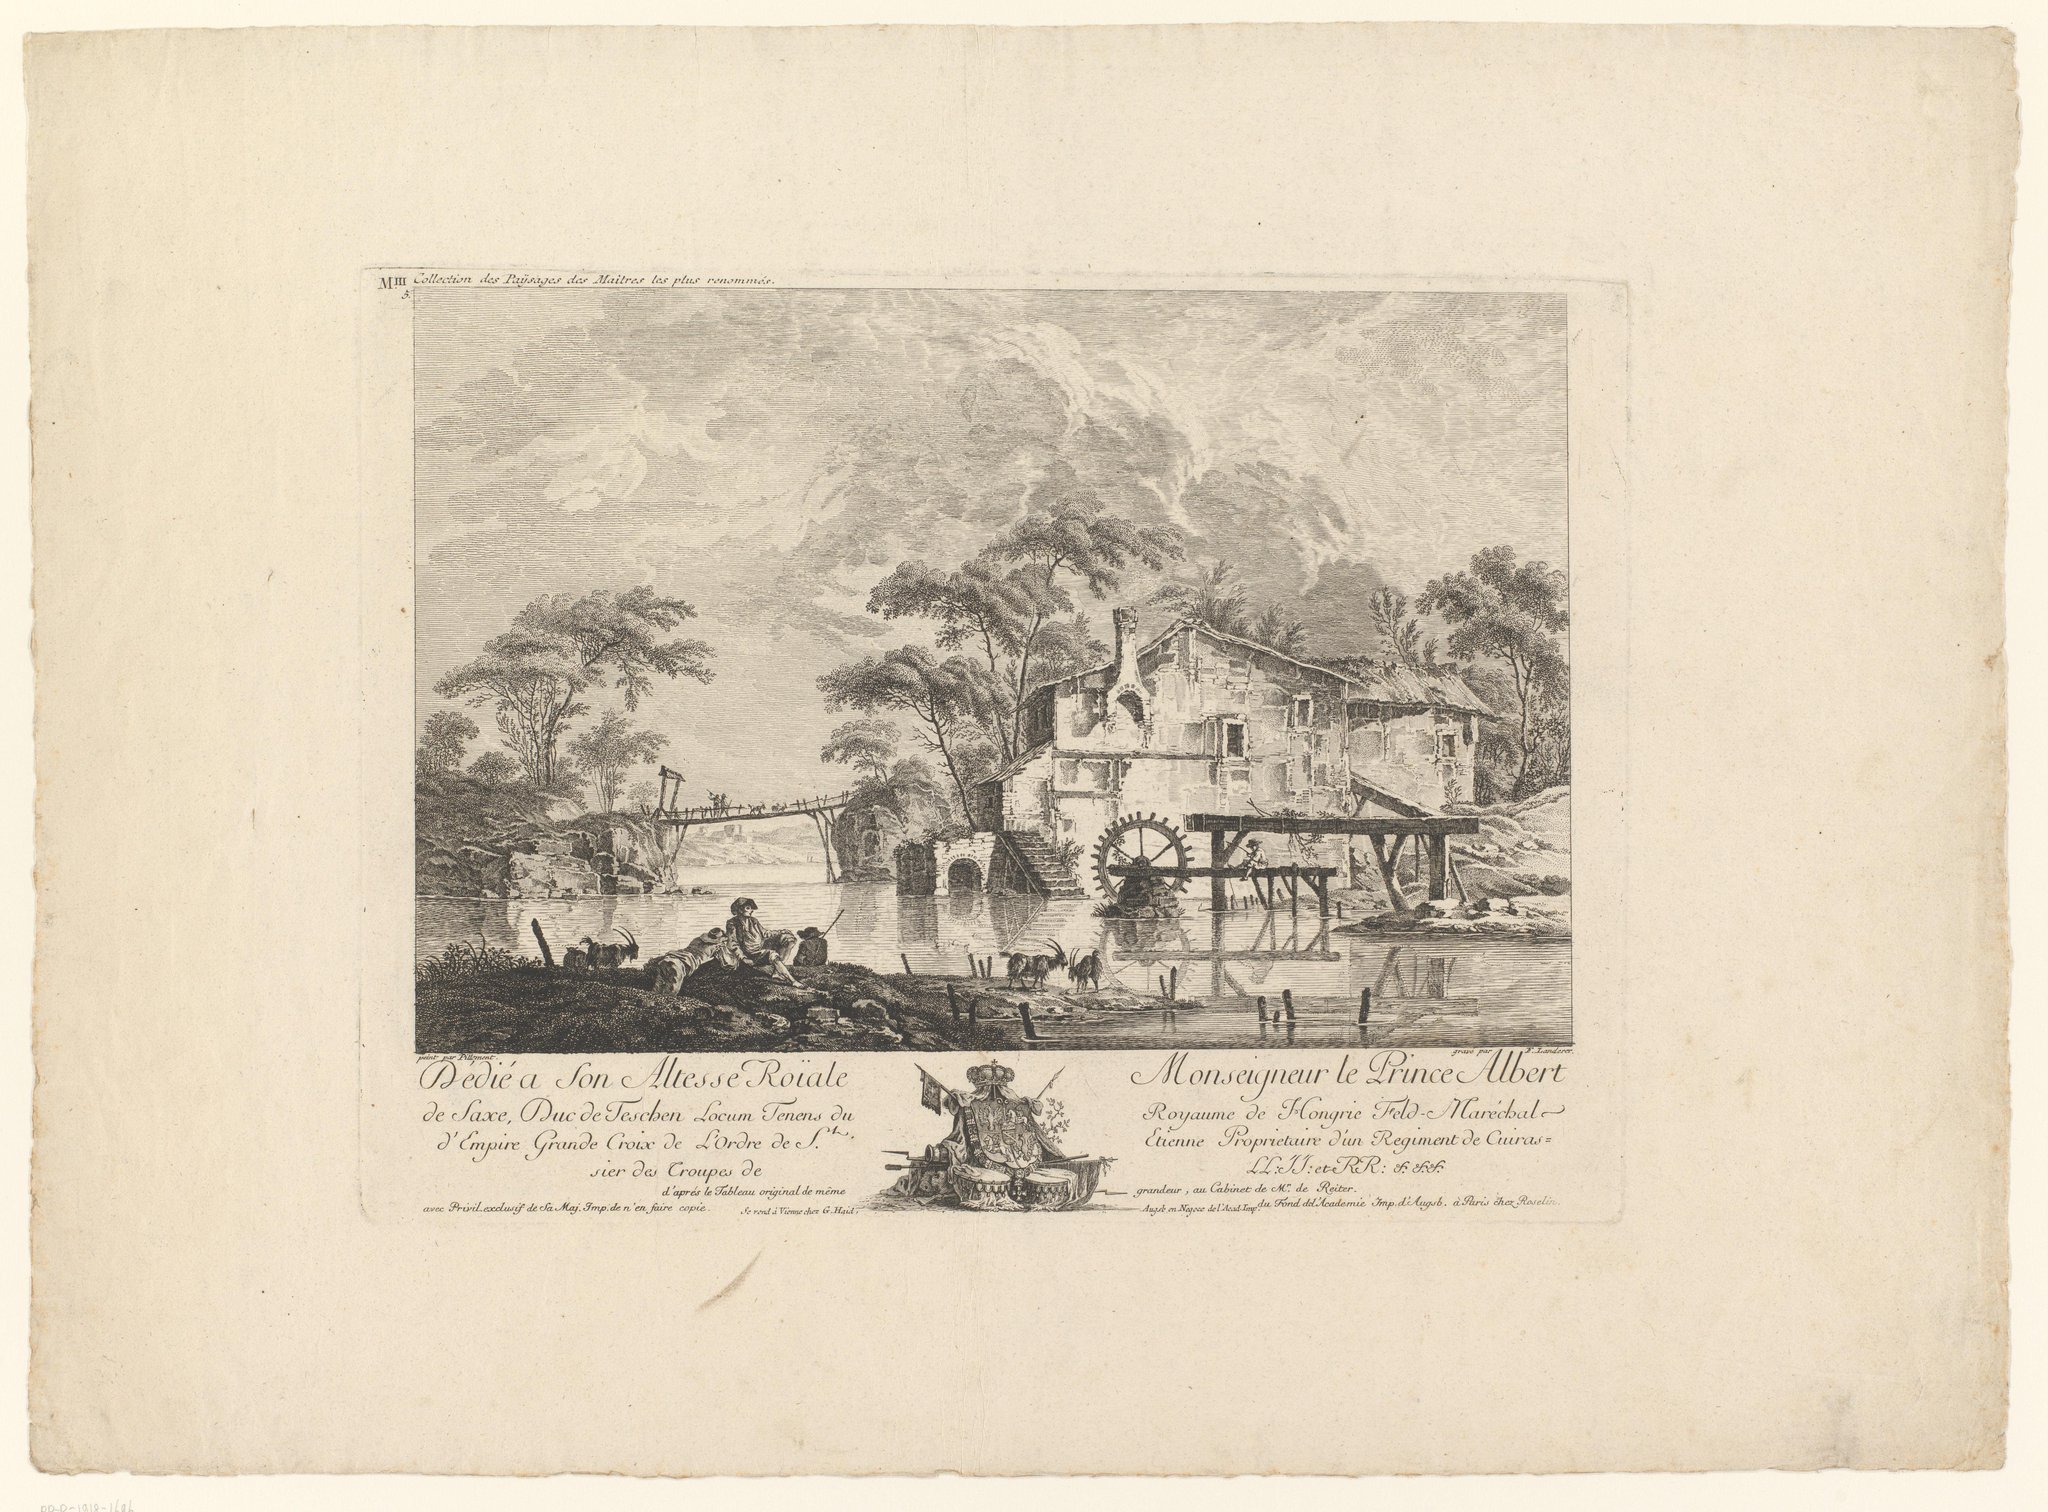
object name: print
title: Collection de Paysages de Pillement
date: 1763-1764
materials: paper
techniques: etching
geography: paris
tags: river, herding, herdsman, herdswoman, shepherd, shepherdess, cowherd, etc., watermill in landscape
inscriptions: collector's mark: Lugt 2233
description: Tekst in het Frans in de boven- en de ondermarge. Linksboven staat 'M III' en nummer 5.